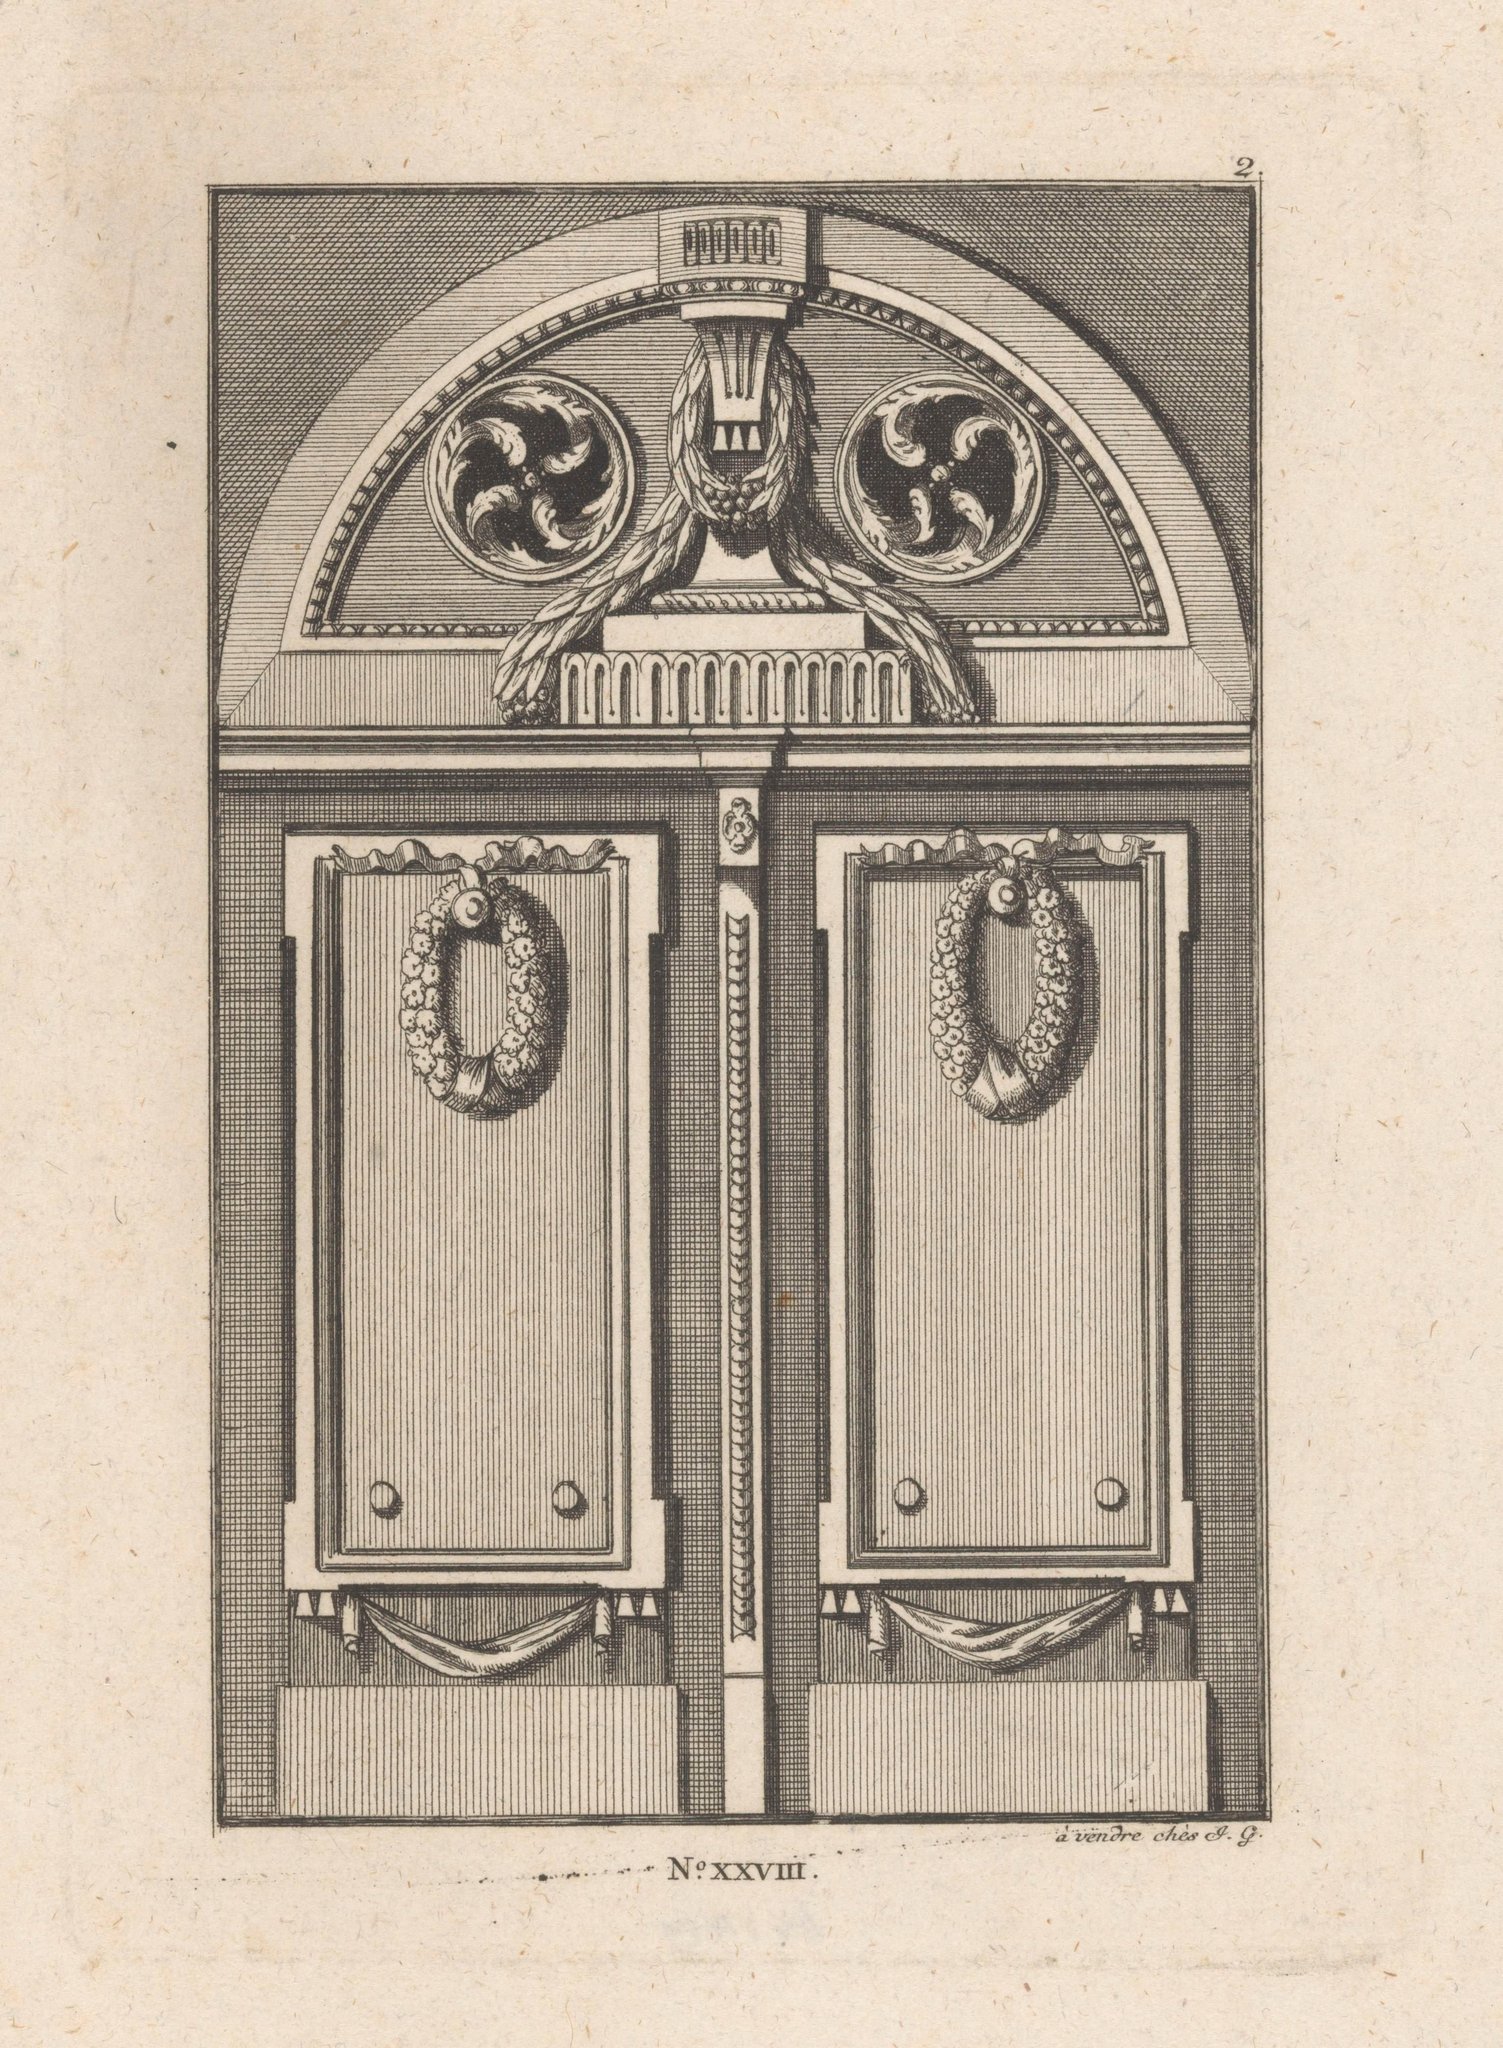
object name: print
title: Muurgraf met guirlandes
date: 1779-1781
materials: paper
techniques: engraving, etching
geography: ravensburg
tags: niche-tomb, wall-tomb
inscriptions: collector's mark: Lugt 2760, collector's mark: Lugt 2228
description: Ontwerp voor een muurgraf geornamenteerd met guirlandes en bloem- en bladmotieven. Uitgeversnummer XXVIII.